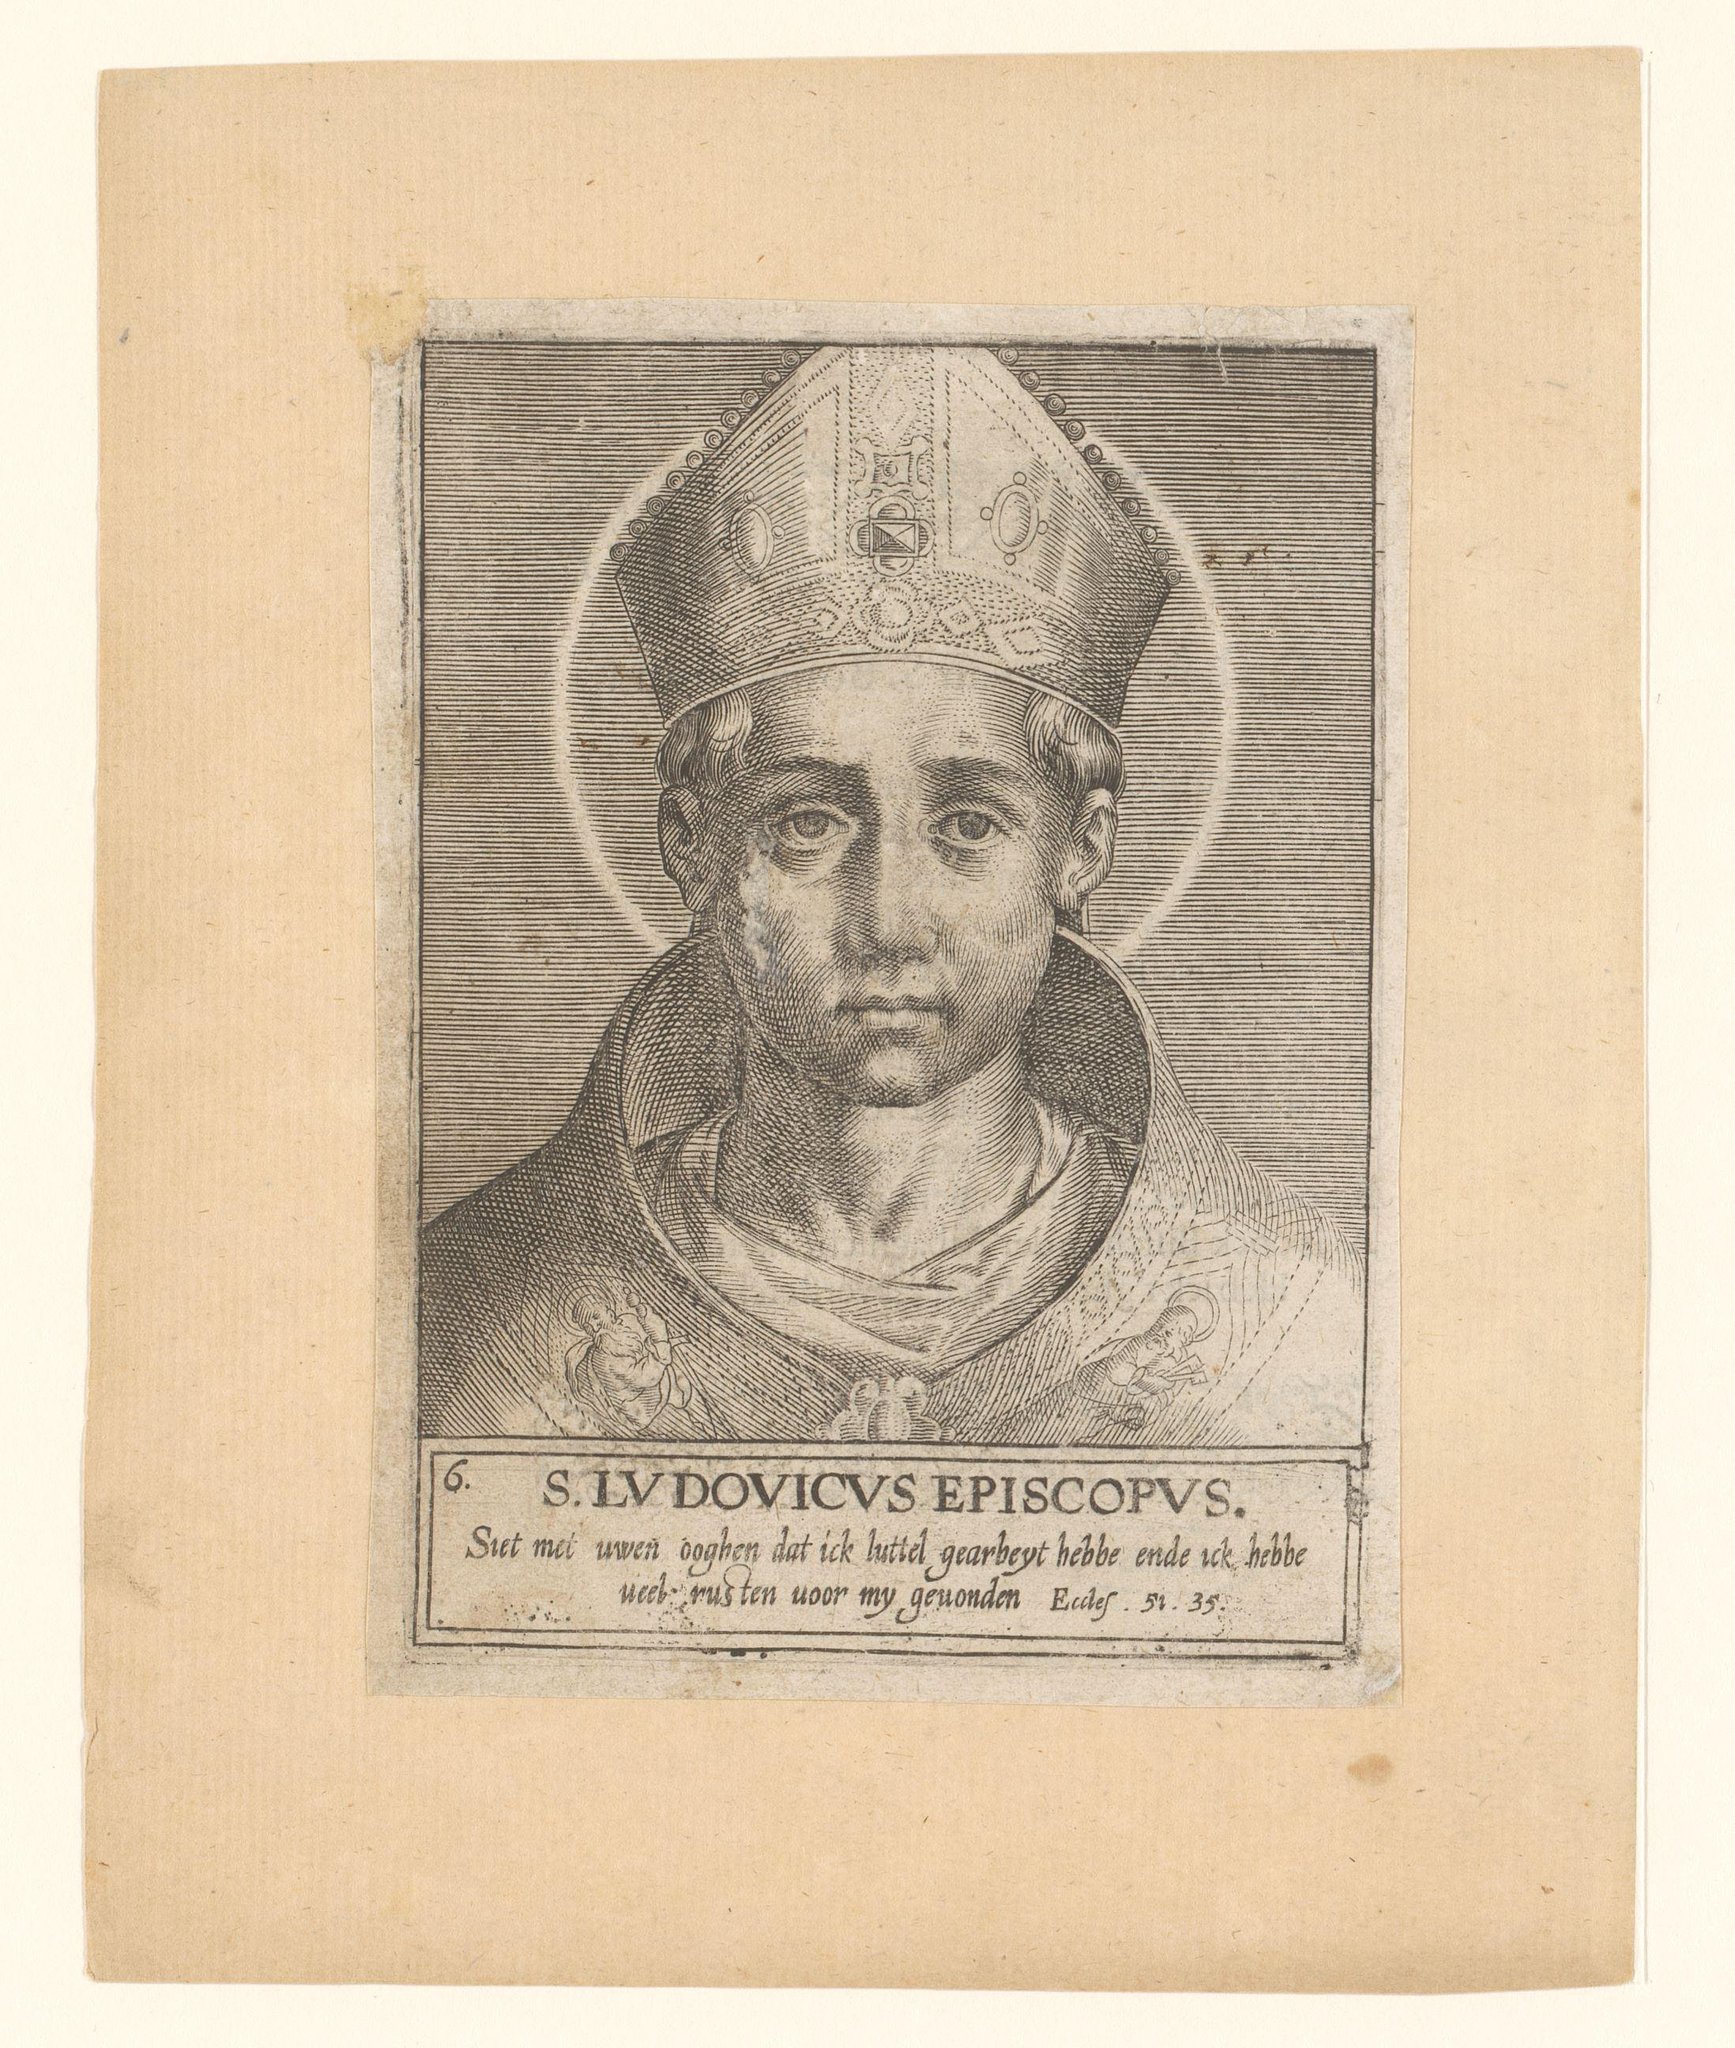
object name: print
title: S. Ludovicus Episcopus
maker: Anonymous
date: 1605-1620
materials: paper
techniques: engraving, letterpress printing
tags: louis of anjou, son of the king of naples, franciscan friar, and bishop of toulouse; possible attributes: fleur-de-lis on his cope, crown and sceptre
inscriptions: collector's mark: Lugt 2228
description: Prent gebruikt in: Thielmans, Cornelius. Cort verhael, van het leven der Heijlighen van S. Franciscus Oirden (...). Den Bosch: Jan van Turnhout, 1605. En in de daaropvolgende uitgaven van 1606 (Den Bosch: Jan Scheffer), 1610 (Den Bosch: Jan van Turnhout) en 1620 (Den Bosch: Jan Scheffer).